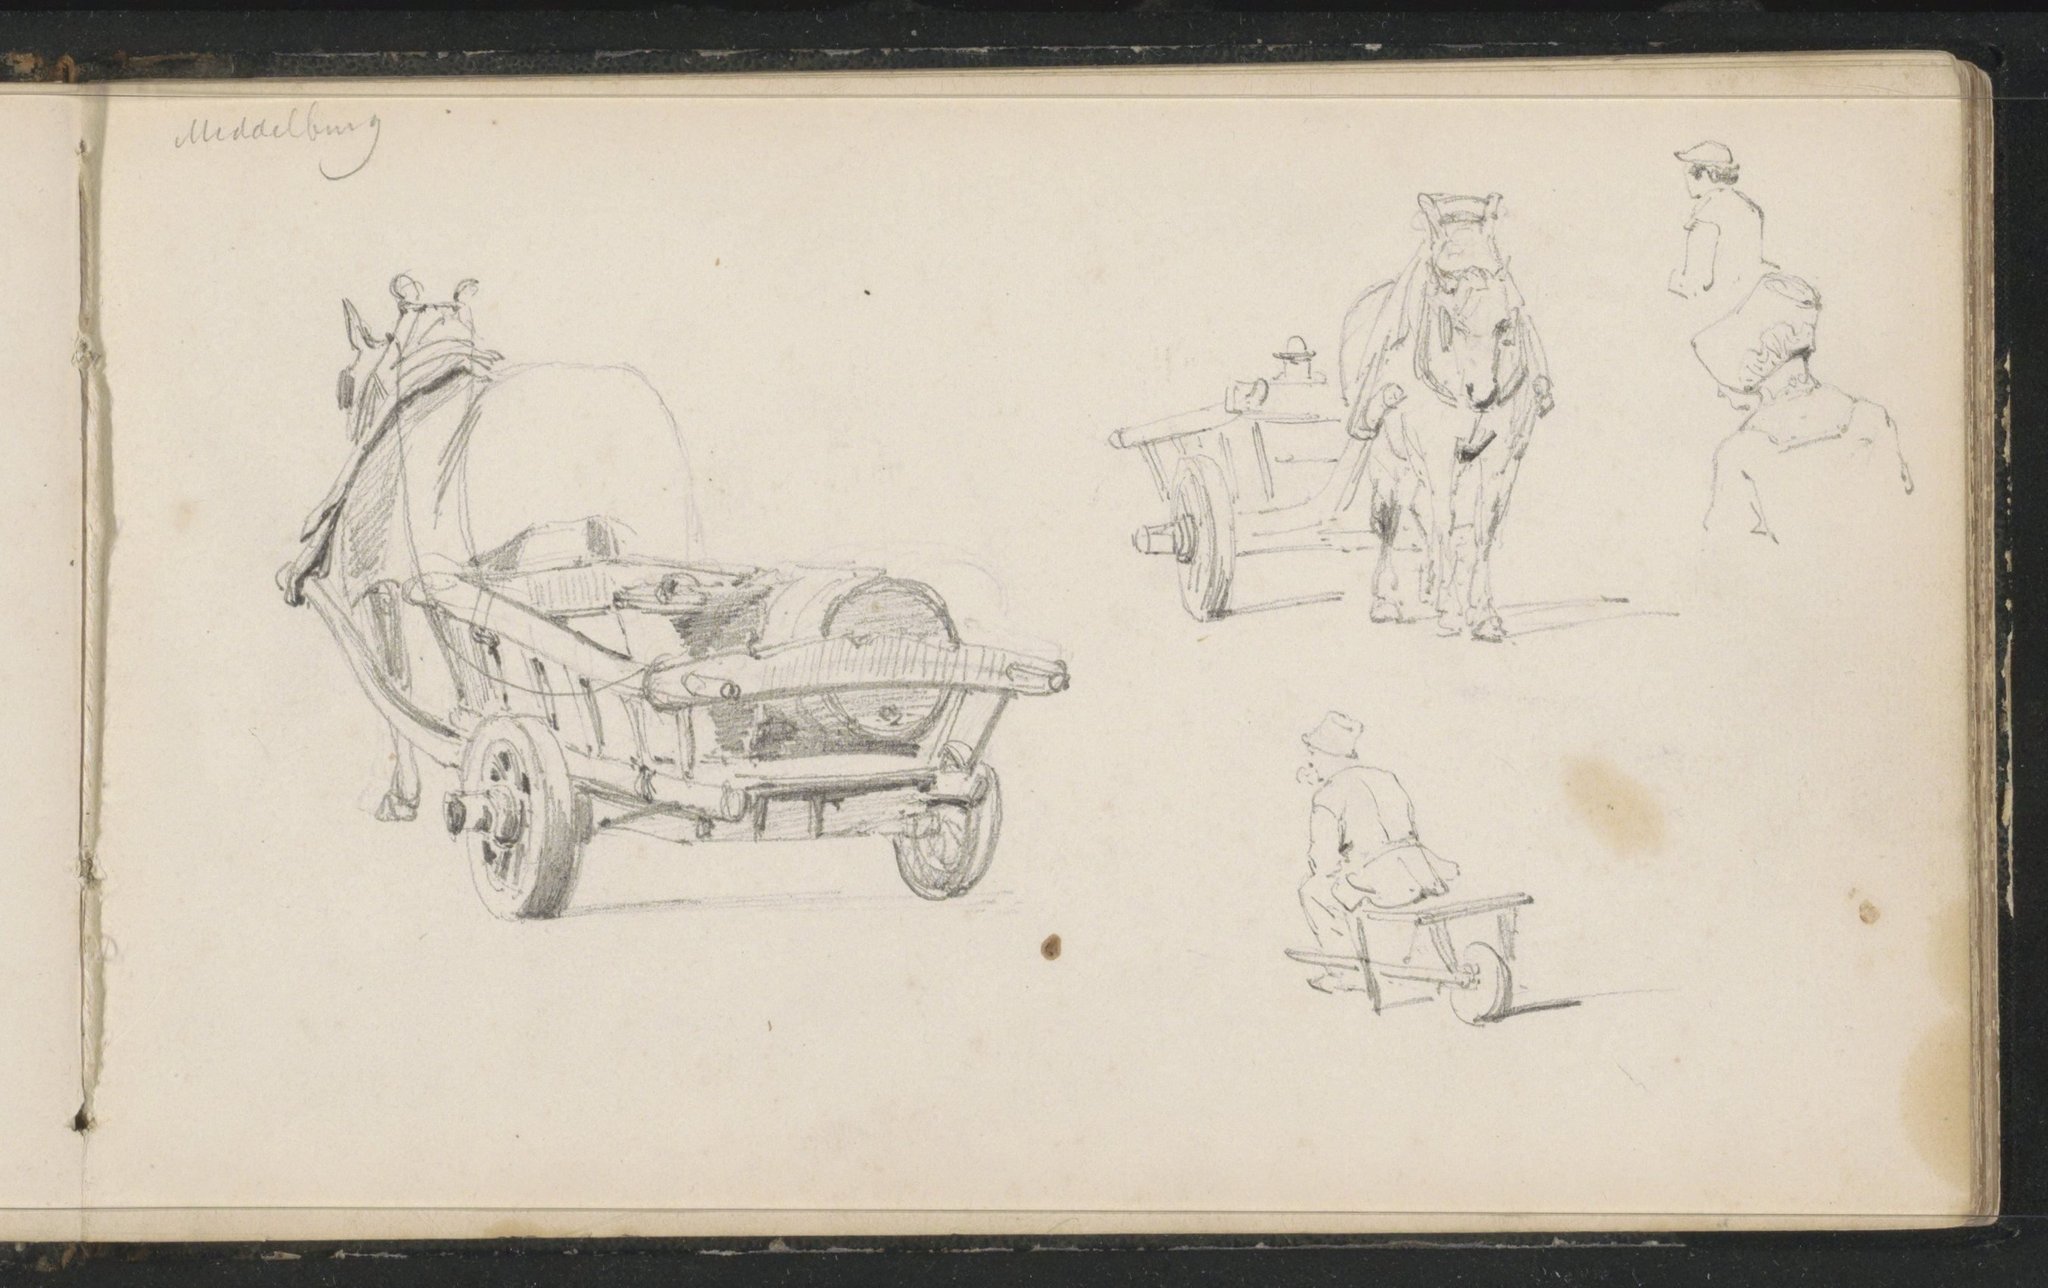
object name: sketchbook leaf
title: Studieblad met karren en figuren te Middelburg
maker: cornelis springer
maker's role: draughtsman, painter, print maker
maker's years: 1817-1891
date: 1856-1861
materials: paper, pencil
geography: middelburg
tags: hand-cart, adult woman, adult man, horse, (farm) wagon, freight wagon, cart, middelburg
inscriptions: annotation: ‘Middelburg’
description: Studieblad met hand- en paardenkarren en figuren te Middelburg. Blad 4 uit een schetsboek met 44 bladen vervaardigd in Zeeland en Utrecht.